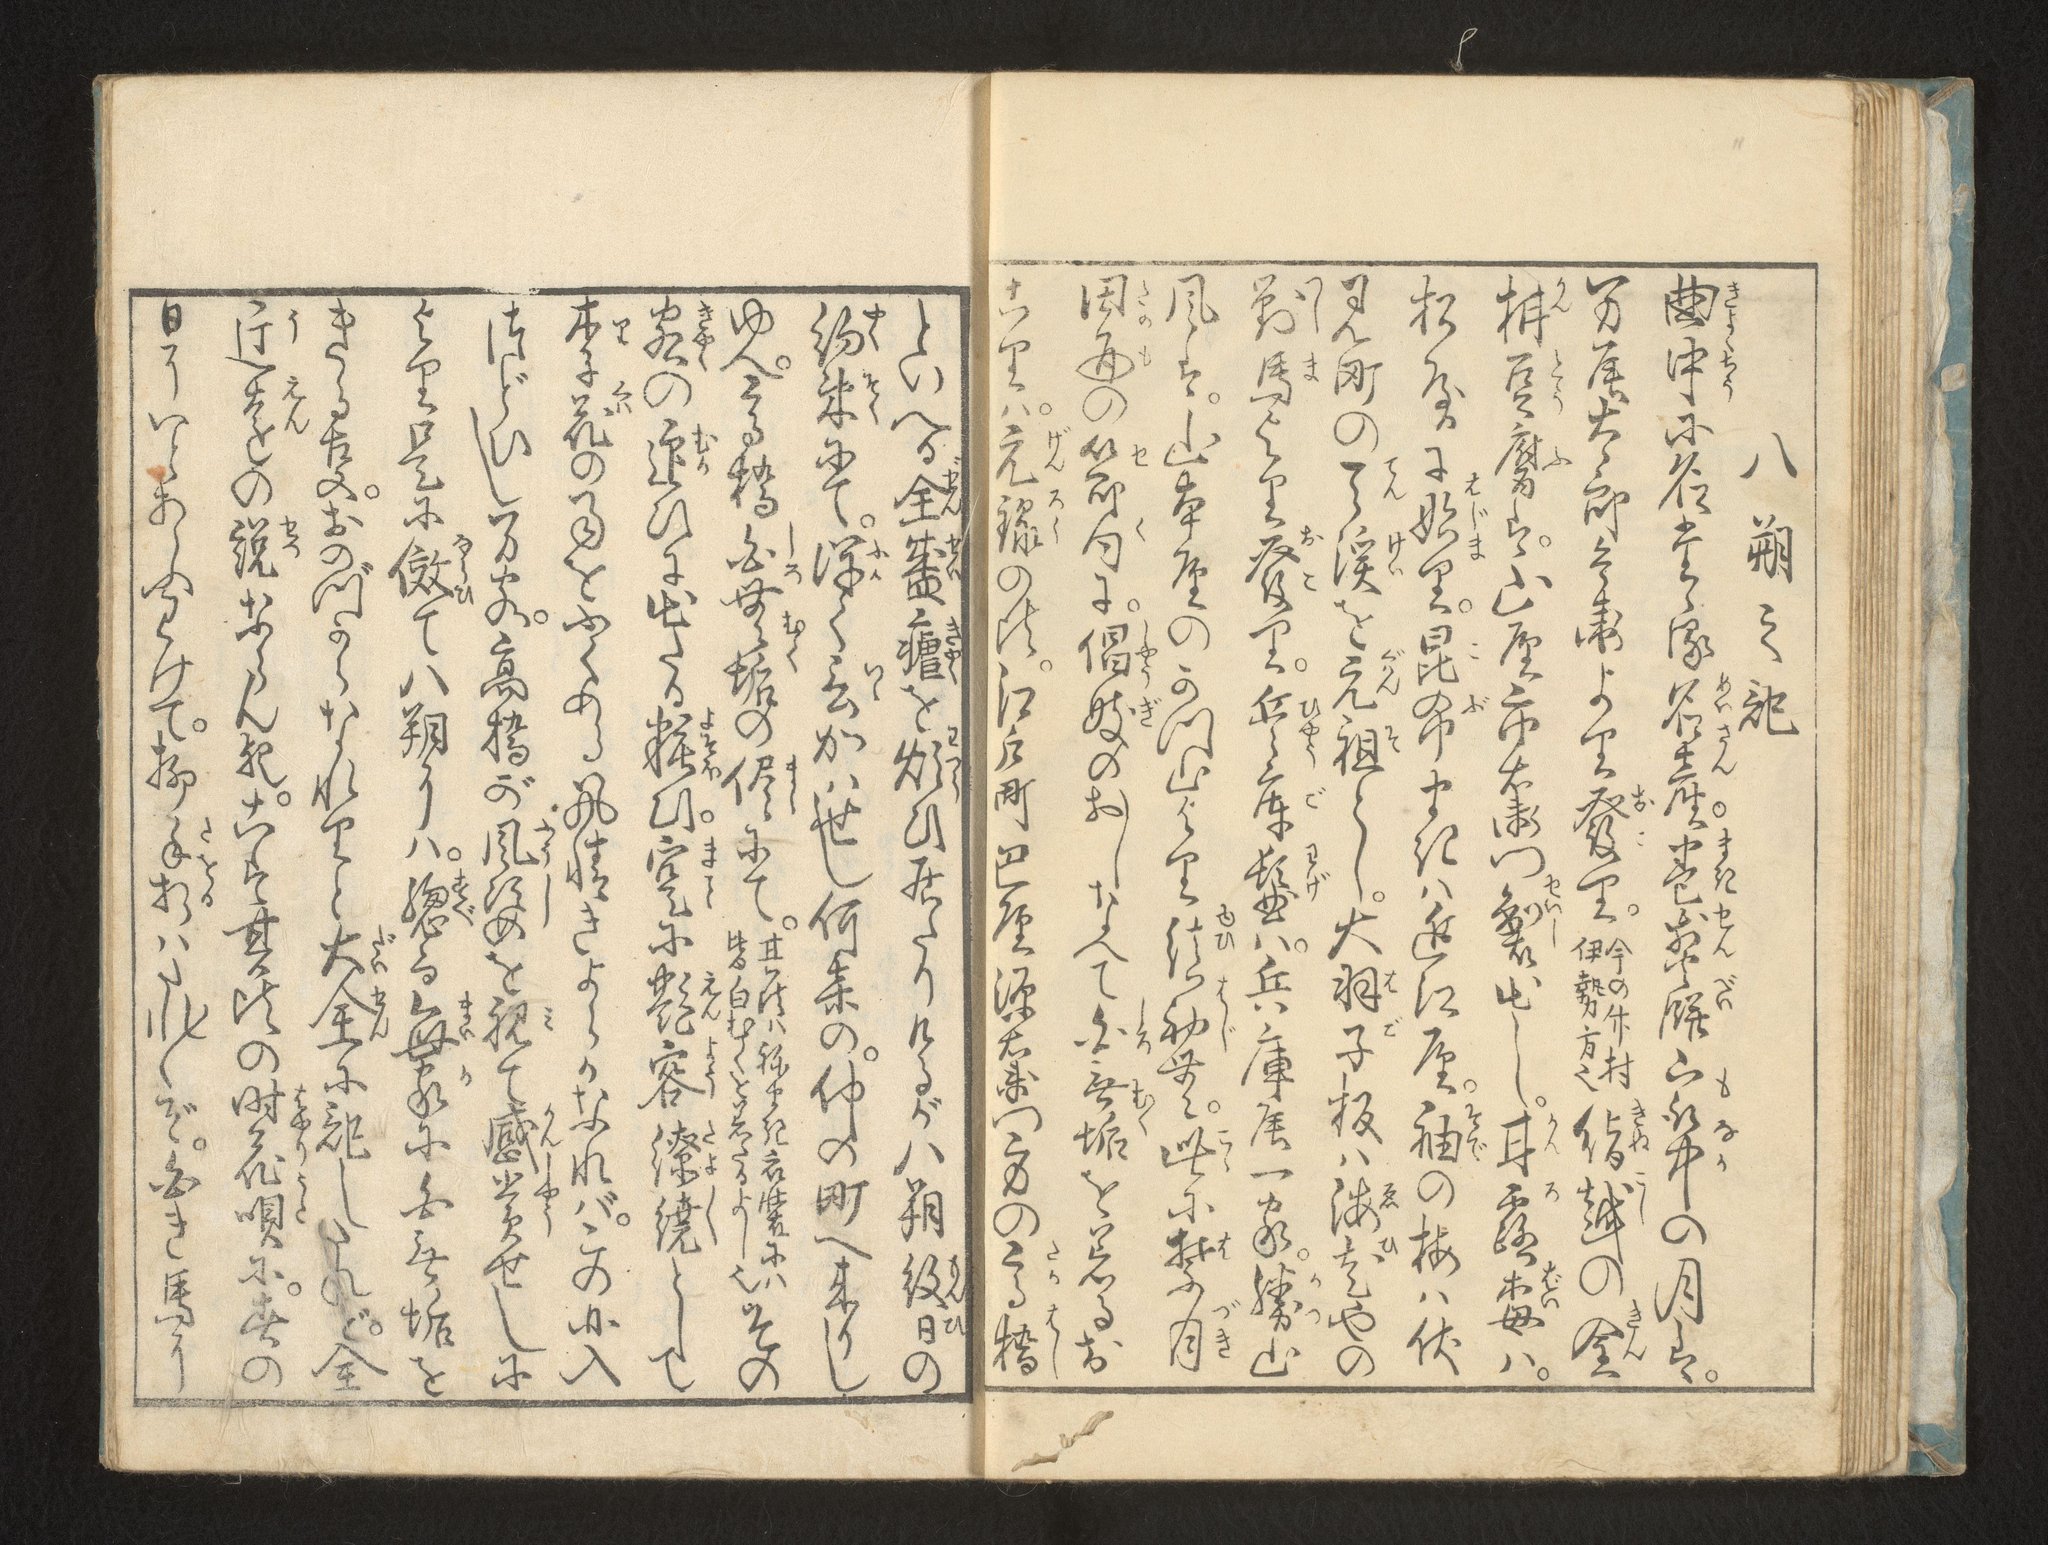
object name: page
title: Tekst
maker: jippensha ikku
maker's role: schrijver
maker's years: 1765-1831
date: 1804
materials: paper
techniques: woodcut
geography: edo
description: Eerste en tweede tekstpagina van deel twee van Utamaro`s boek: Gebeurtenissen in de lusthuizen gedurende het jaar.